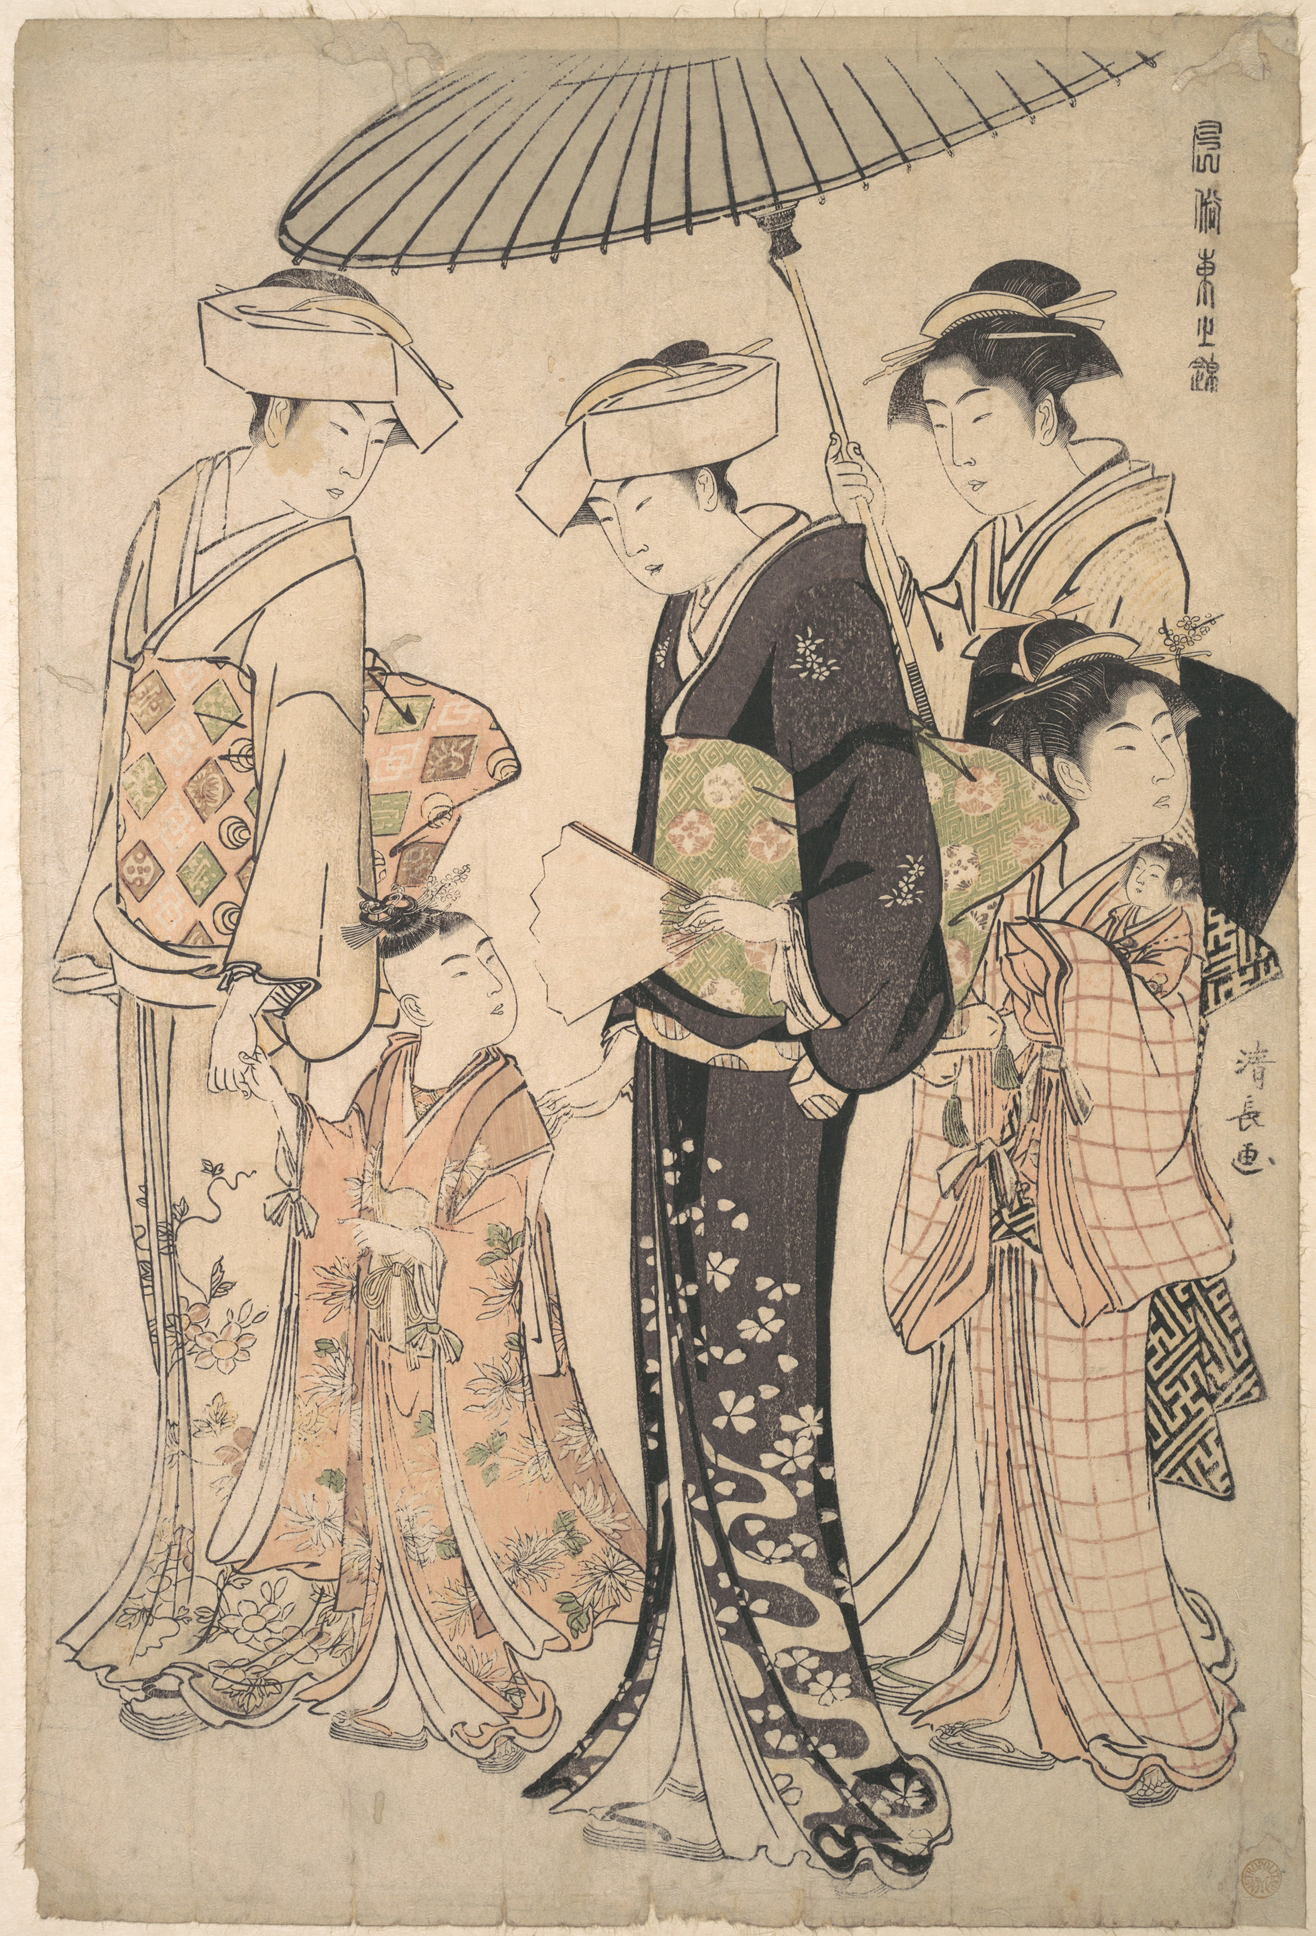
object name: print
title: Two Women in Summer Costume Taking a Young Girl to a Shinto Temple for the Miya Mairi Ceremony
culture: japanese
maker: torii kiyonaga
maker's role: artist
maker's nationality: japanese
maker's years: 1752-1815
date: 1783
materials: ink, paper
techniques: woodblock print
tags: girls,women